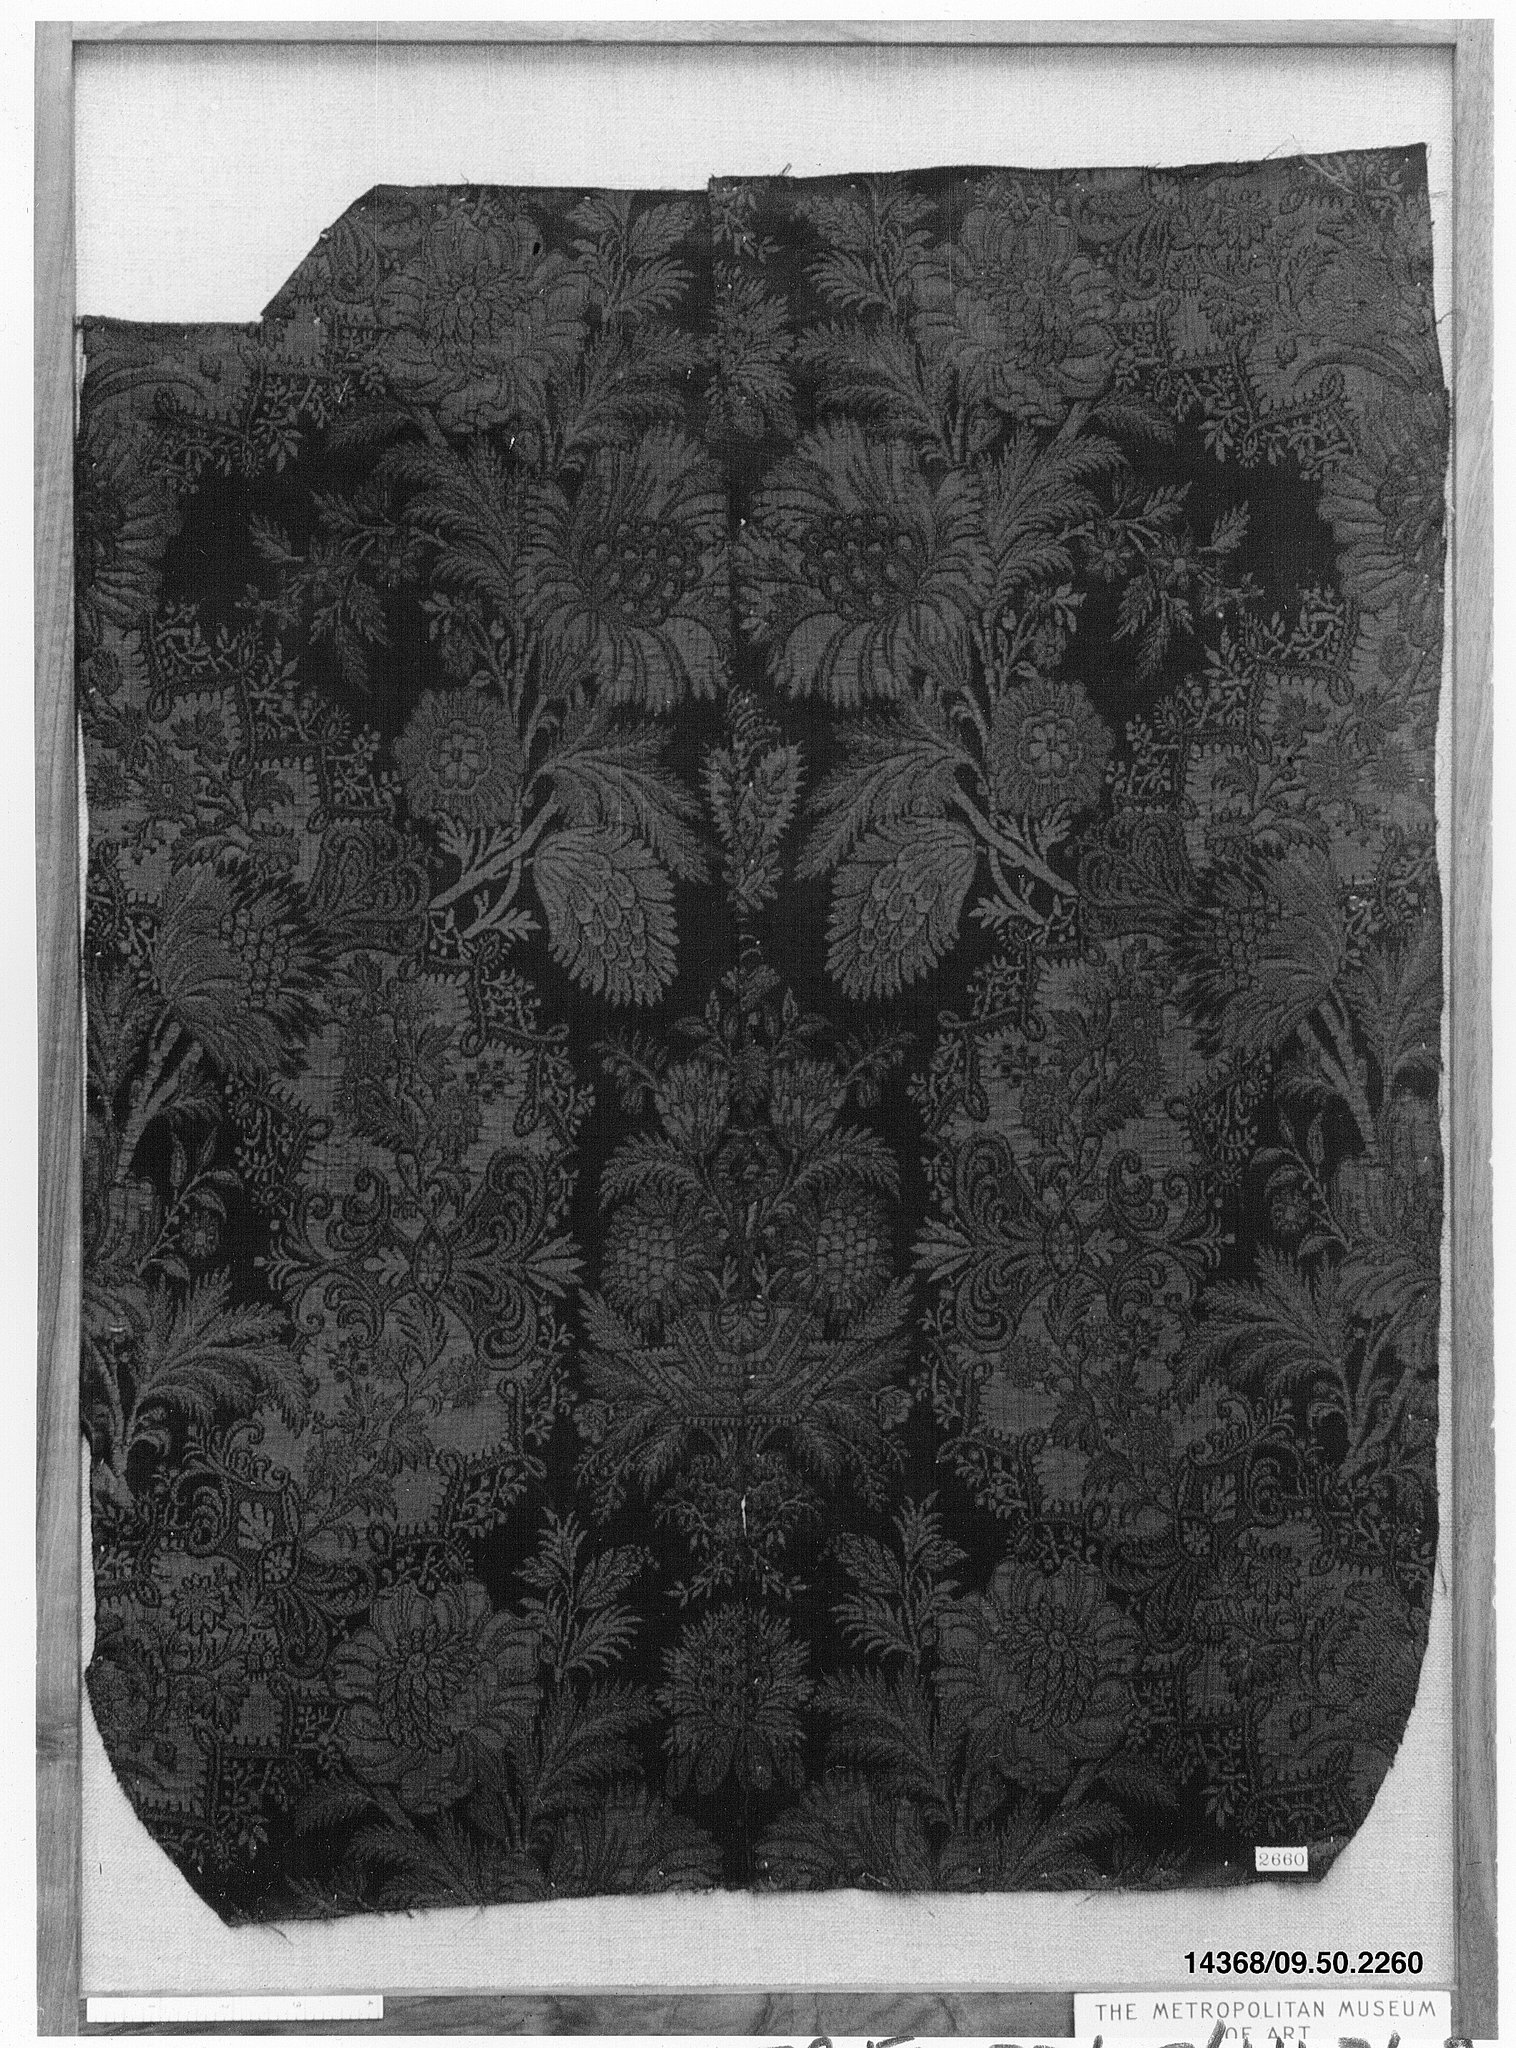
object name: piece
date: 1725-1730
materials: silk